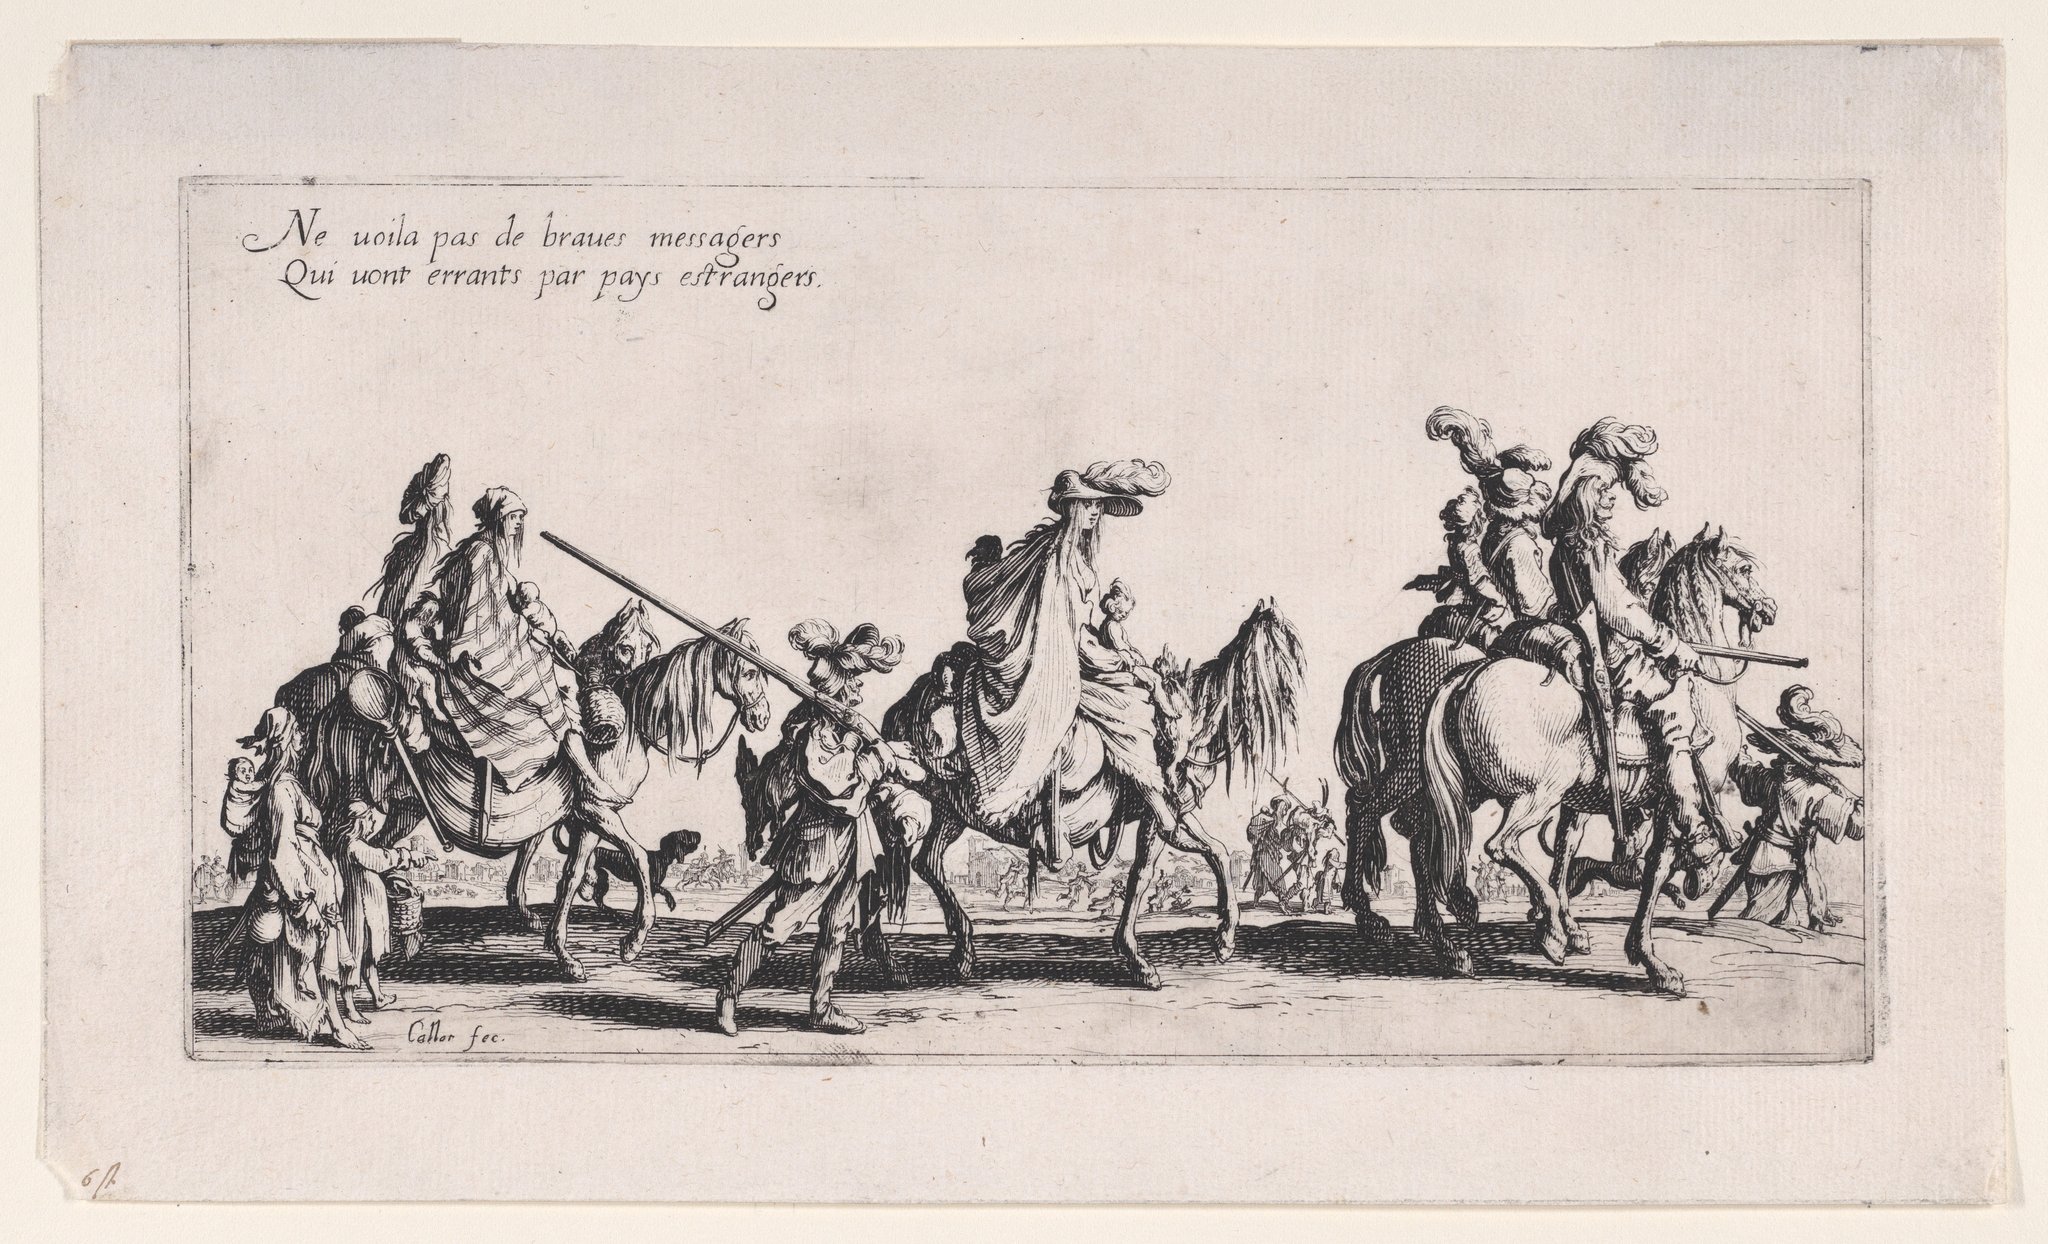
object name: print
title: Les Bohémiens en Marche, pièce aussi appelée L'Avant-Garde (The Gypsies Travelling, piece also called The Advance Gard), from Le Bohémiens, série appelée aussi Les Égyptiens, La Marche des Bohémiens, La Vie Errante des Bohémiens, Les Marches Égyptiennes (The Gypsies, series also called The Egyptians, The Gypsy Troops, The Wandering Lives of Gypsies, The Egyptian Troops)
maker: jacques callot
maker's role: artist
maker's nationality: french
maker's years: 1592-1635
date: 1601-1633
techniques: engraving, etching